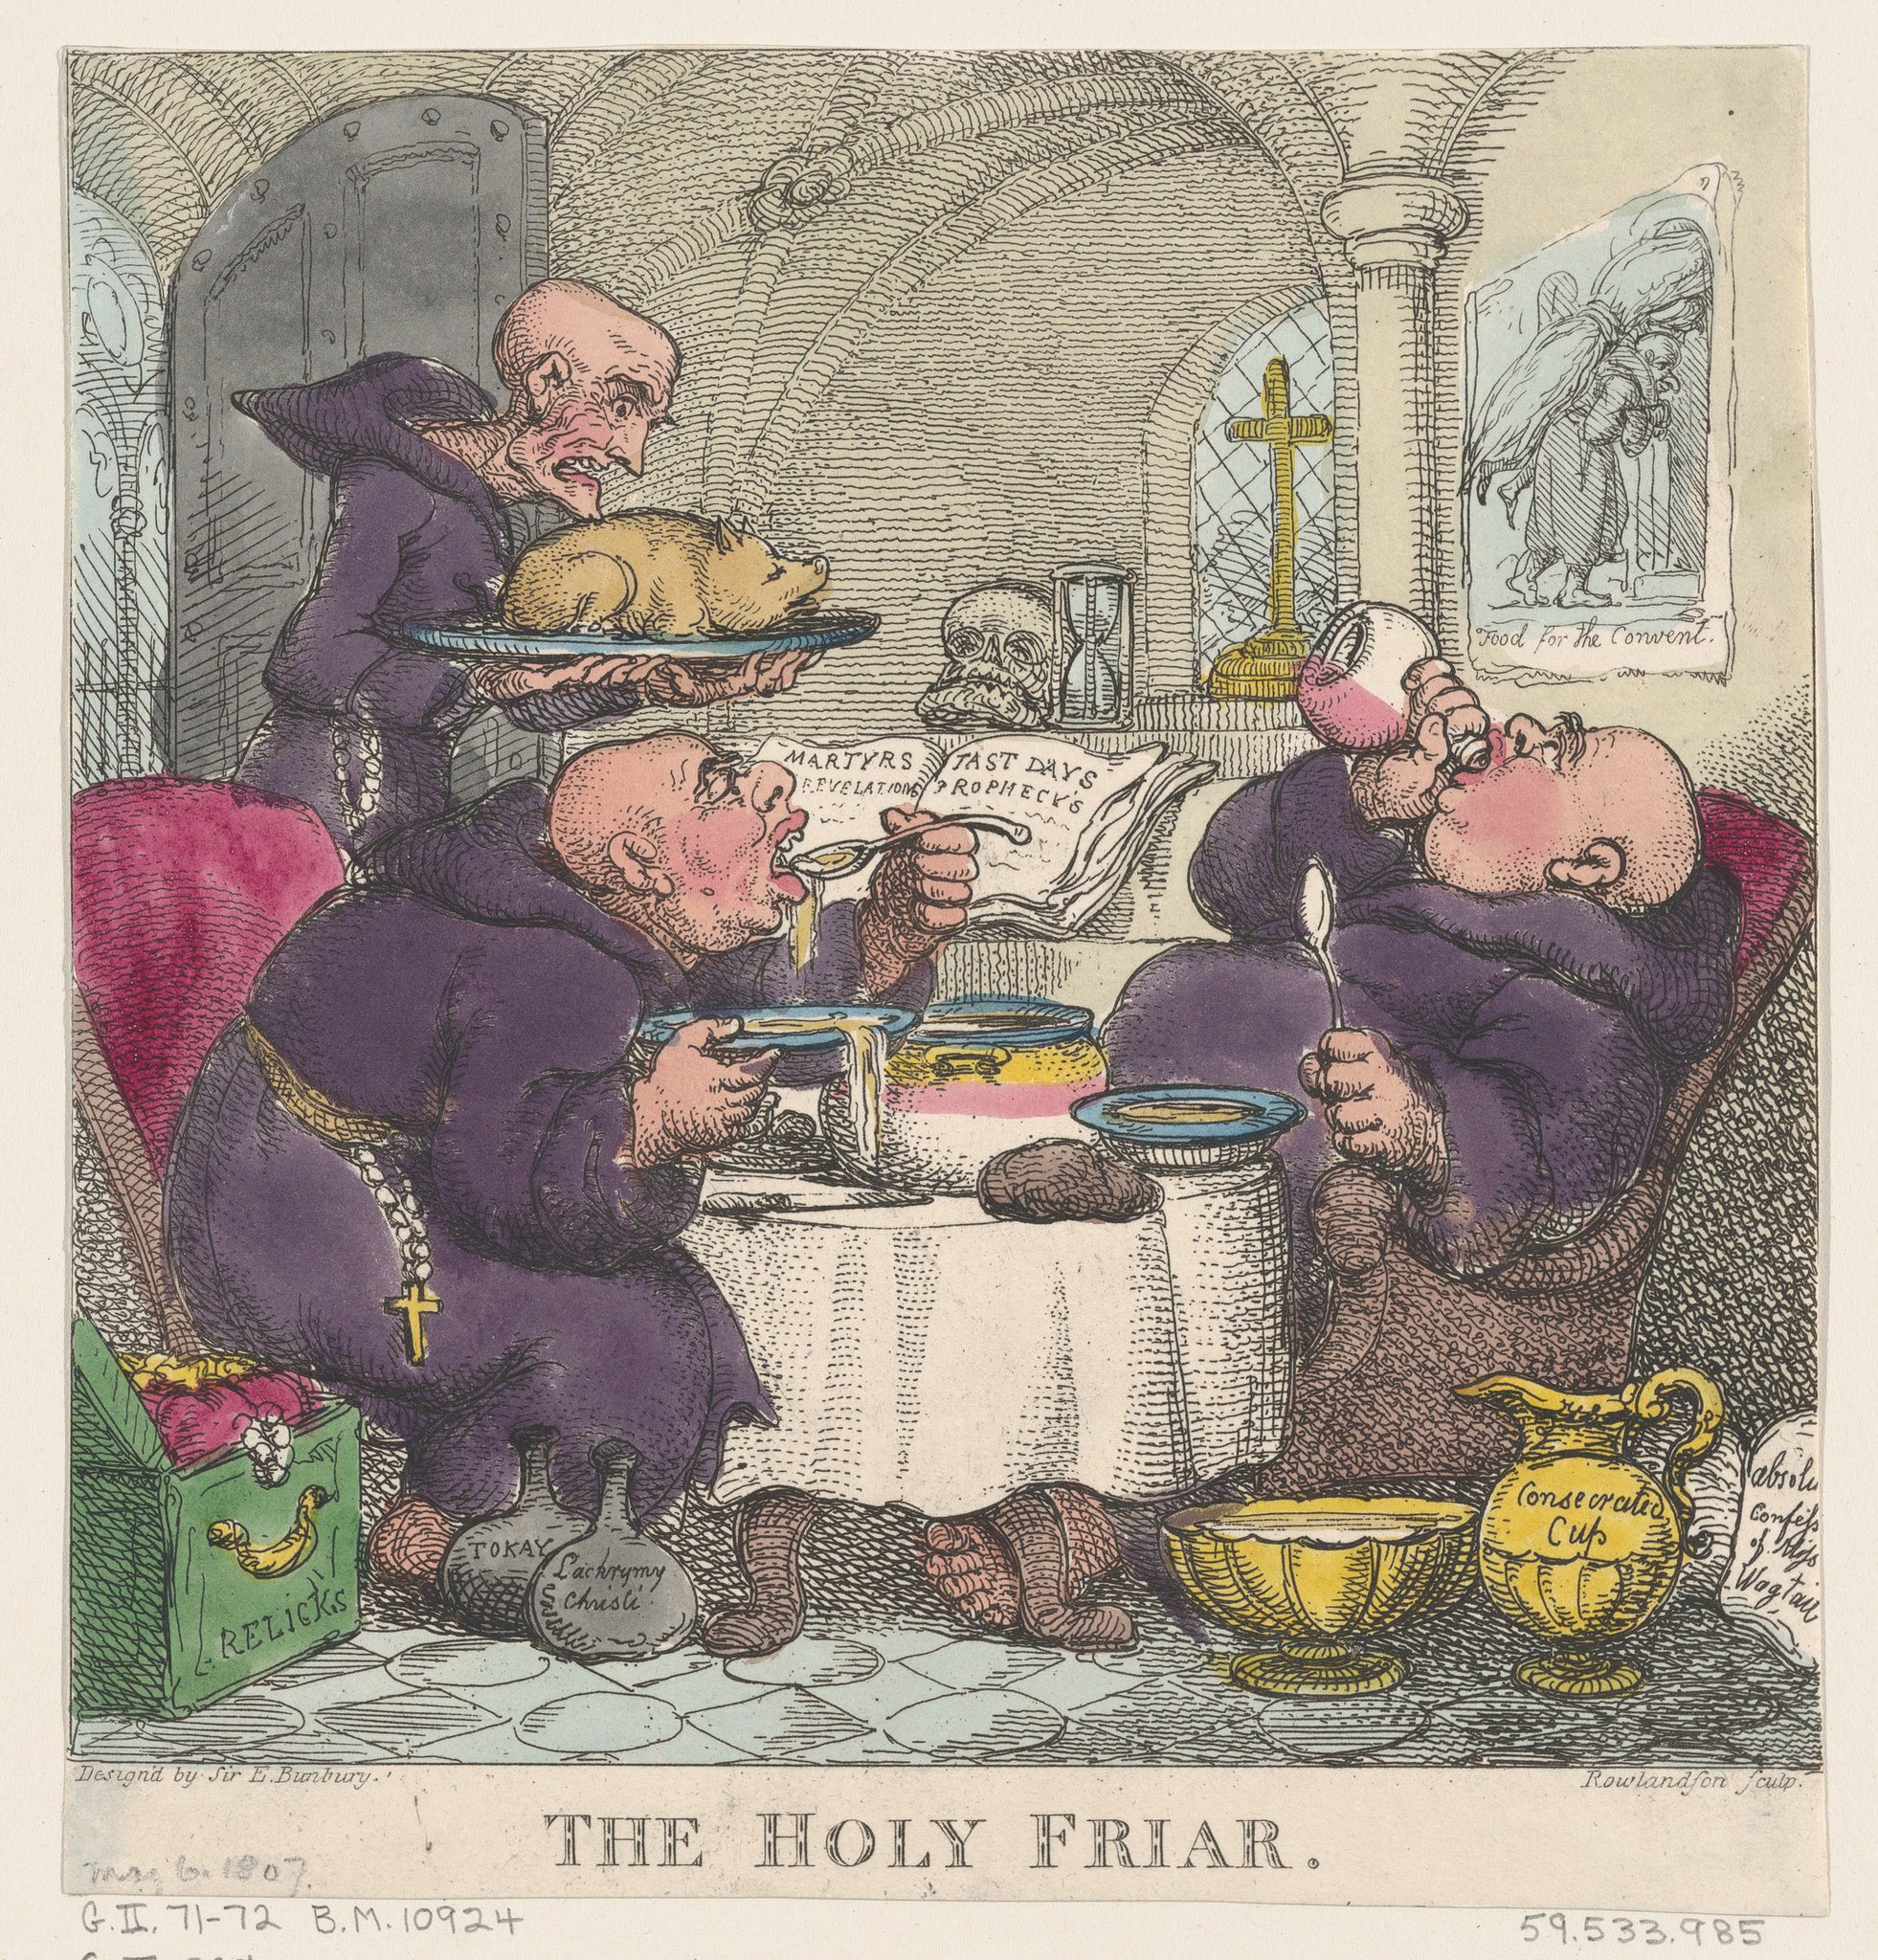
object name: print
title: The Holy Friar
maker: thomas rowlandson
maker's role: artist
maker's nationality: british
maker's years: 1757-1827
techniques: etching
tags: food,men,pigs,drinking